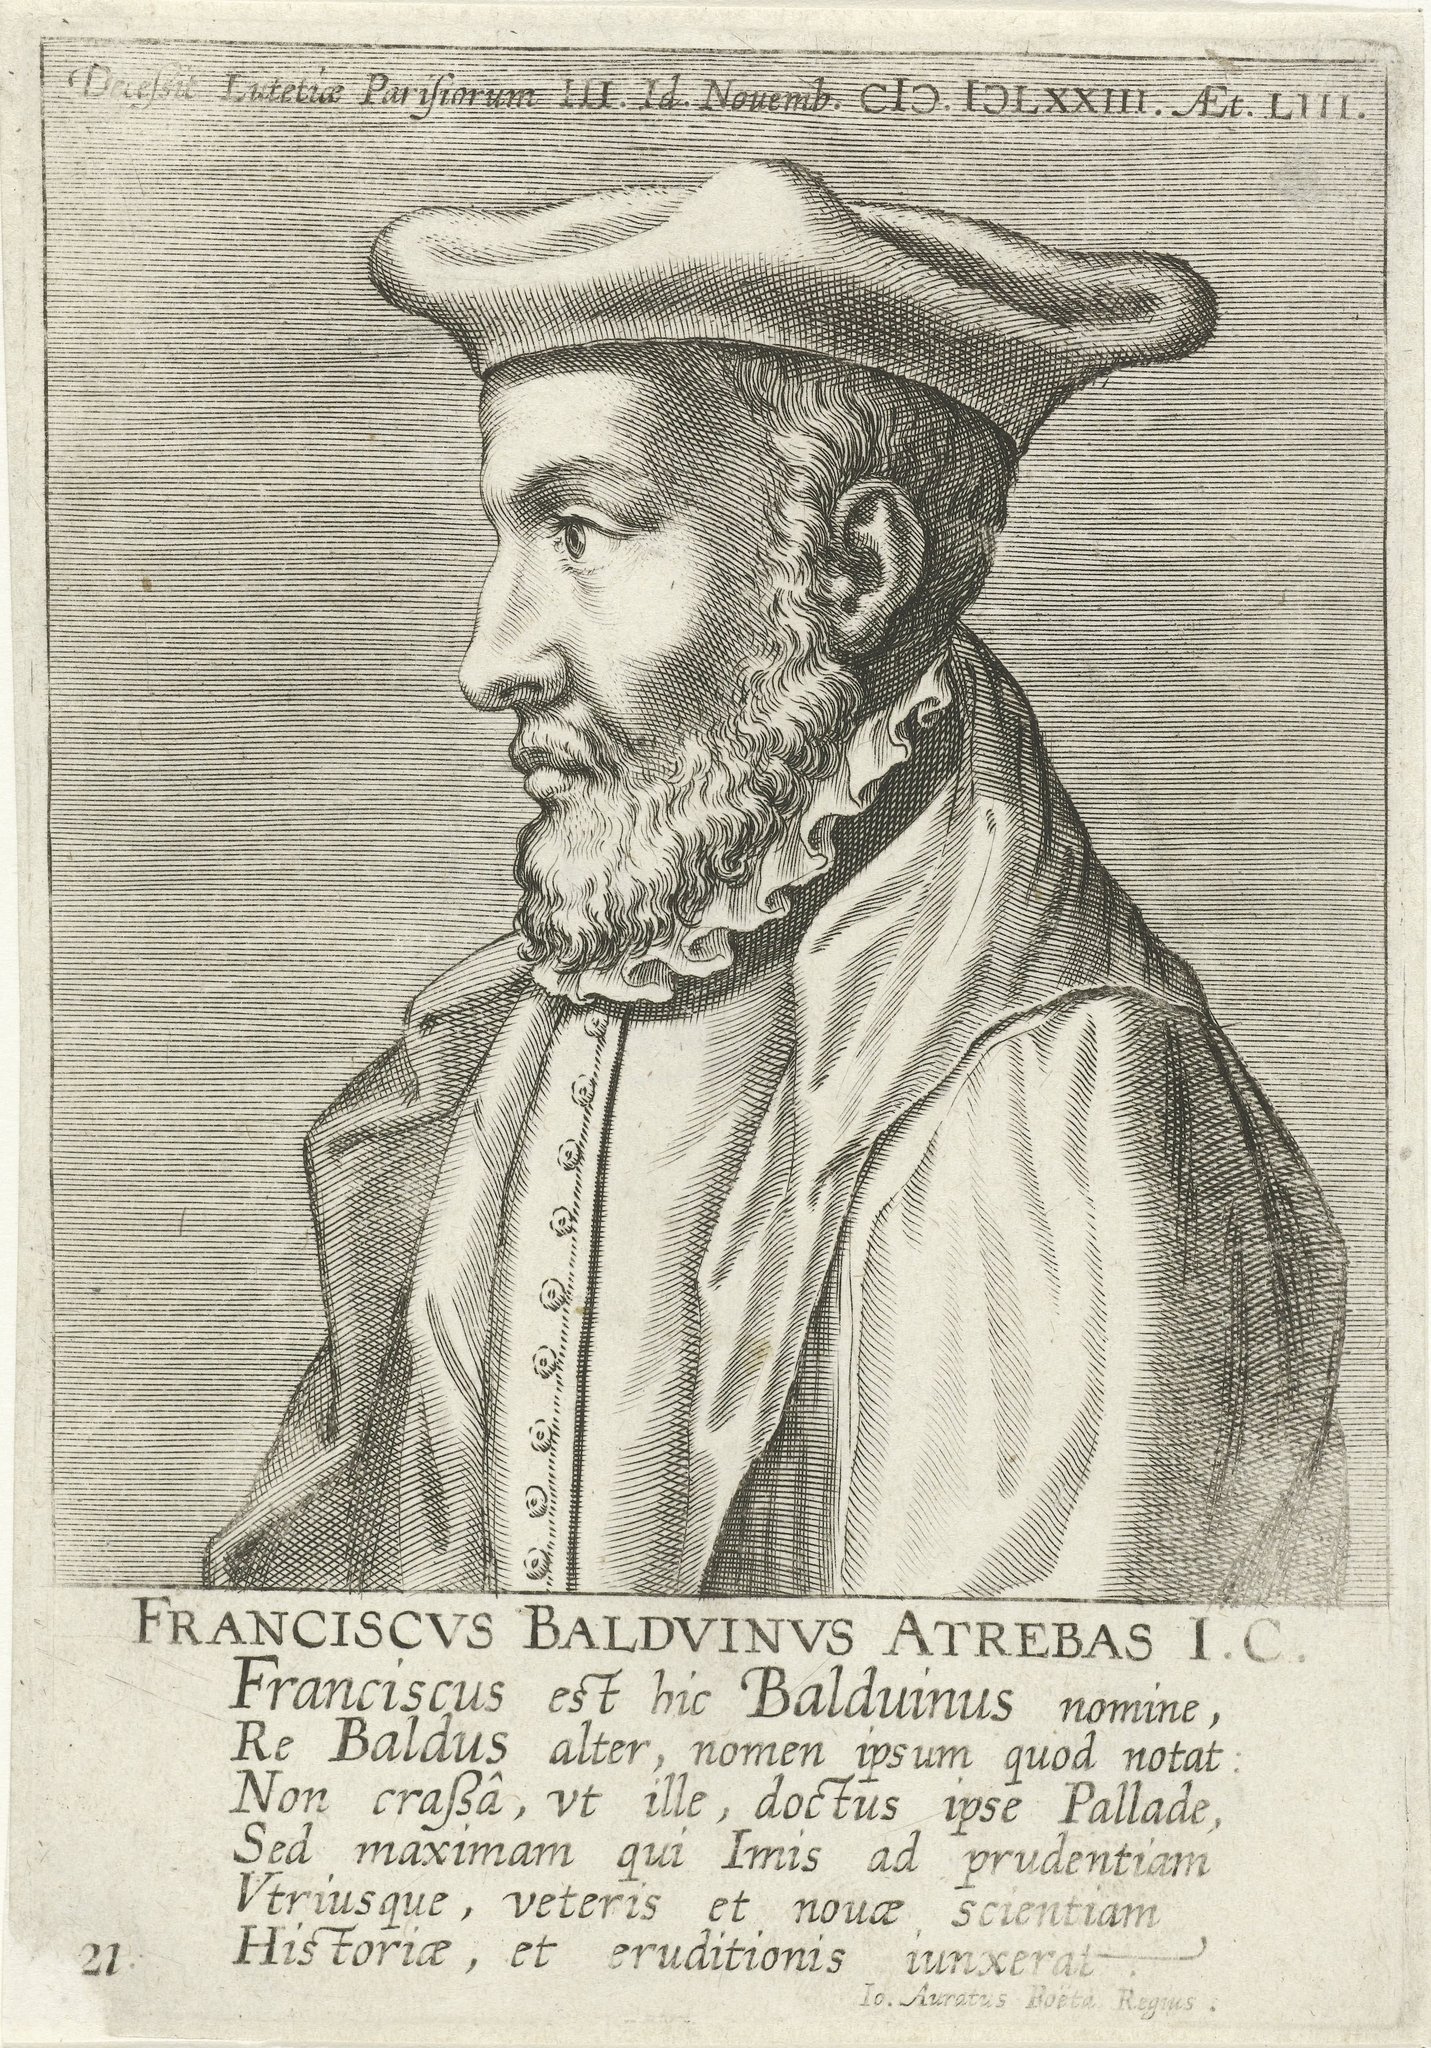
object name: print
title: Portretten van beroemde Nederlandse en Vlaamse geleerden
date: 1604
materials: paper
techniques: engraving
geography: antwerp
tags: paris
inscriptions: collector's mark: Lugt 2228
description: Portret van François Baudoin, Franse jurist en theoloog. Buste naar links. De prent heeft een Latijns boven- en onderschrift en maakt deel uit van een serie van beroemde Nederlandse en Vlaamse geleerden.